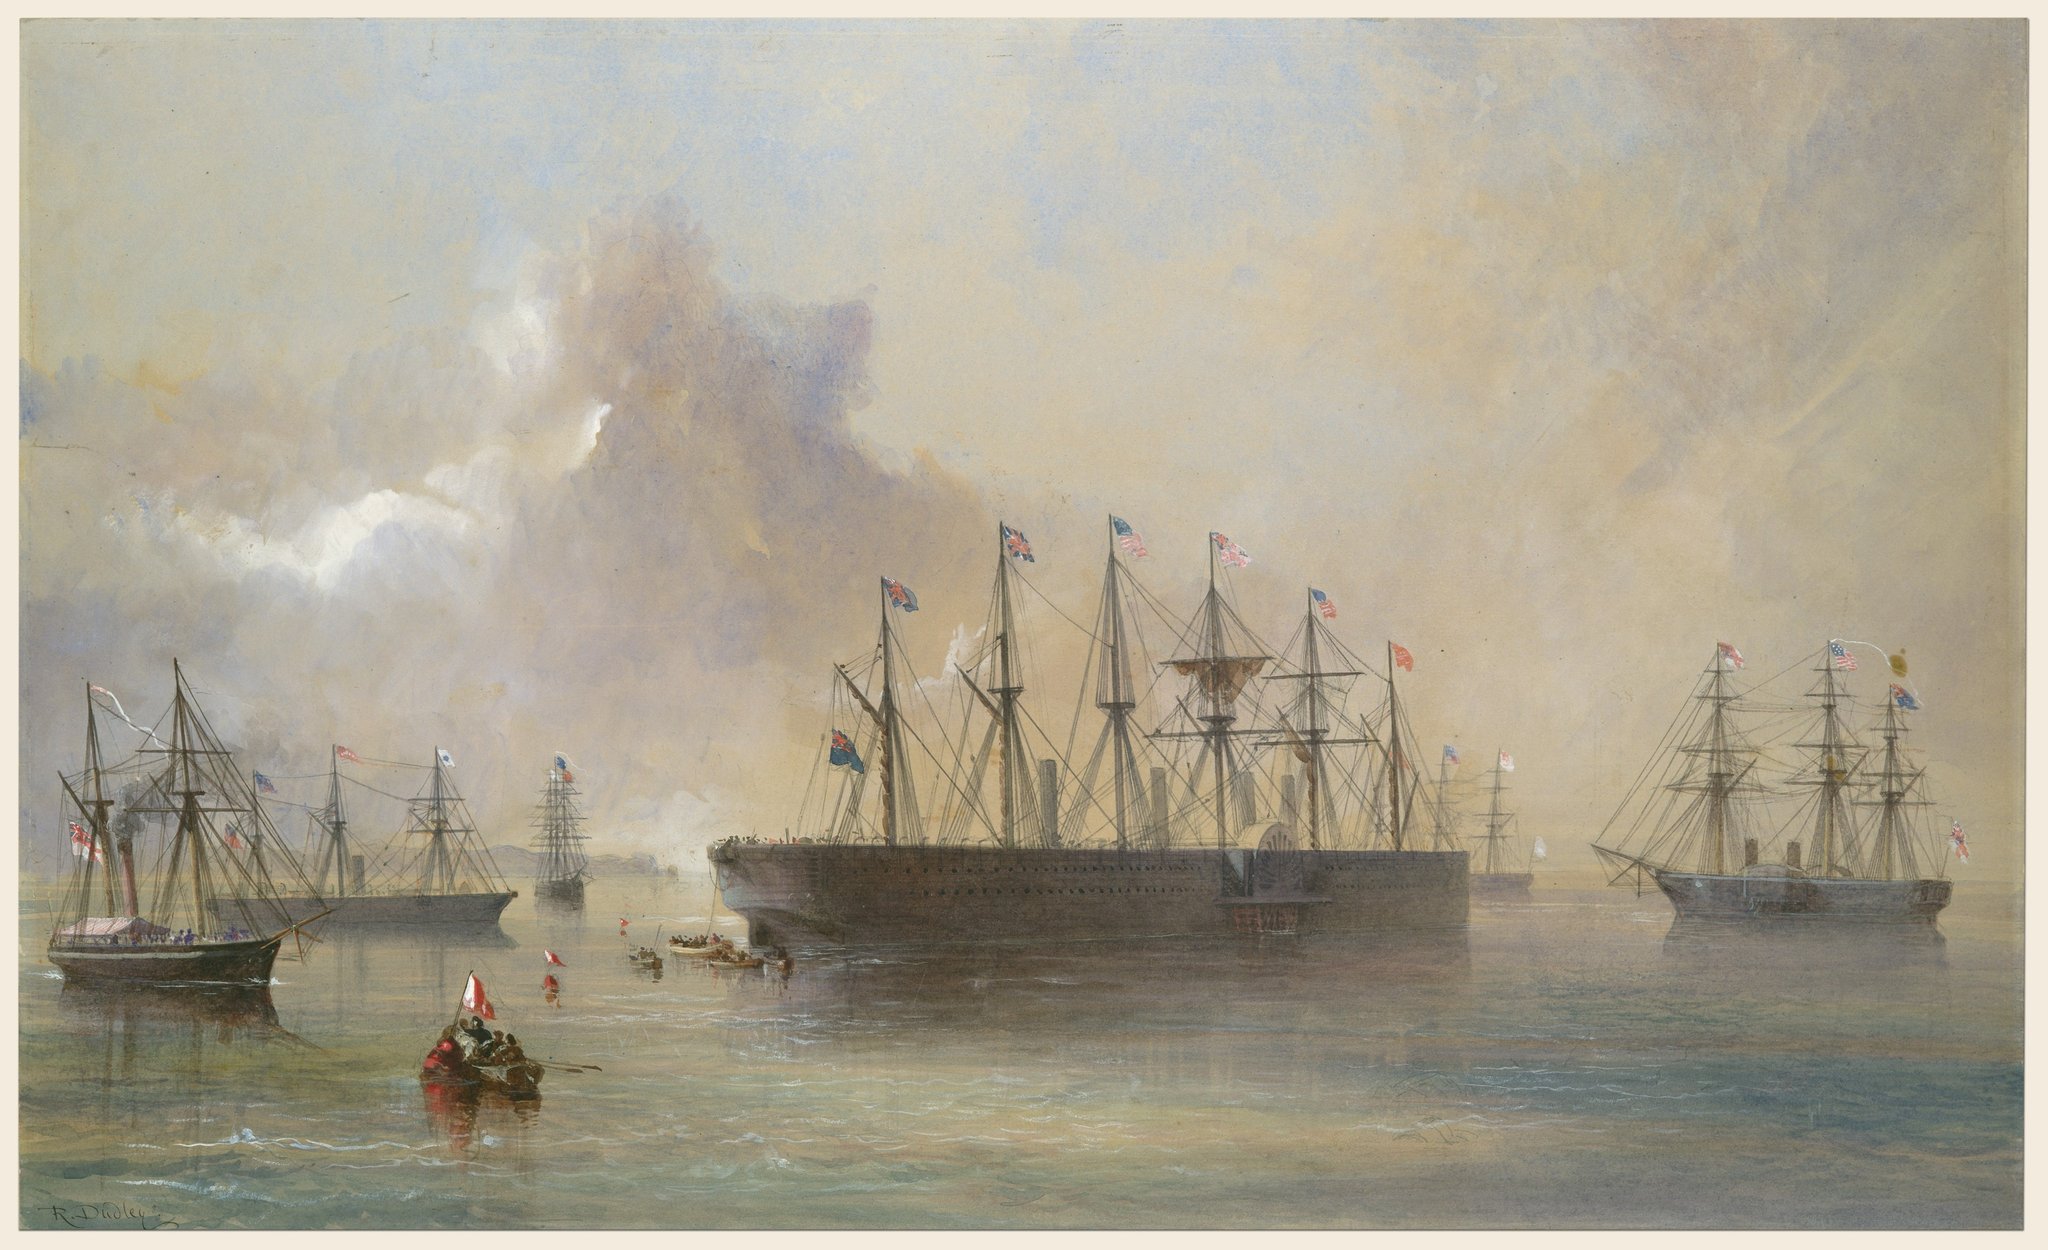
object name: drawing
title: The Atlantic Telegraph Cable Fleet Assembled at Berehaven (Southwest Coast of Ireland): Ships, the Great Eastern, H.M.S. Terrible, the Alby, the Medway and the William Cory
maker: robert charles dudley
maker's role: artist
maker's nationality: british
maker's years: 1826-1909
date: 1866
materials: gouache, graphite, watercolor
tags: industry,boats,ships,transatlantic cable